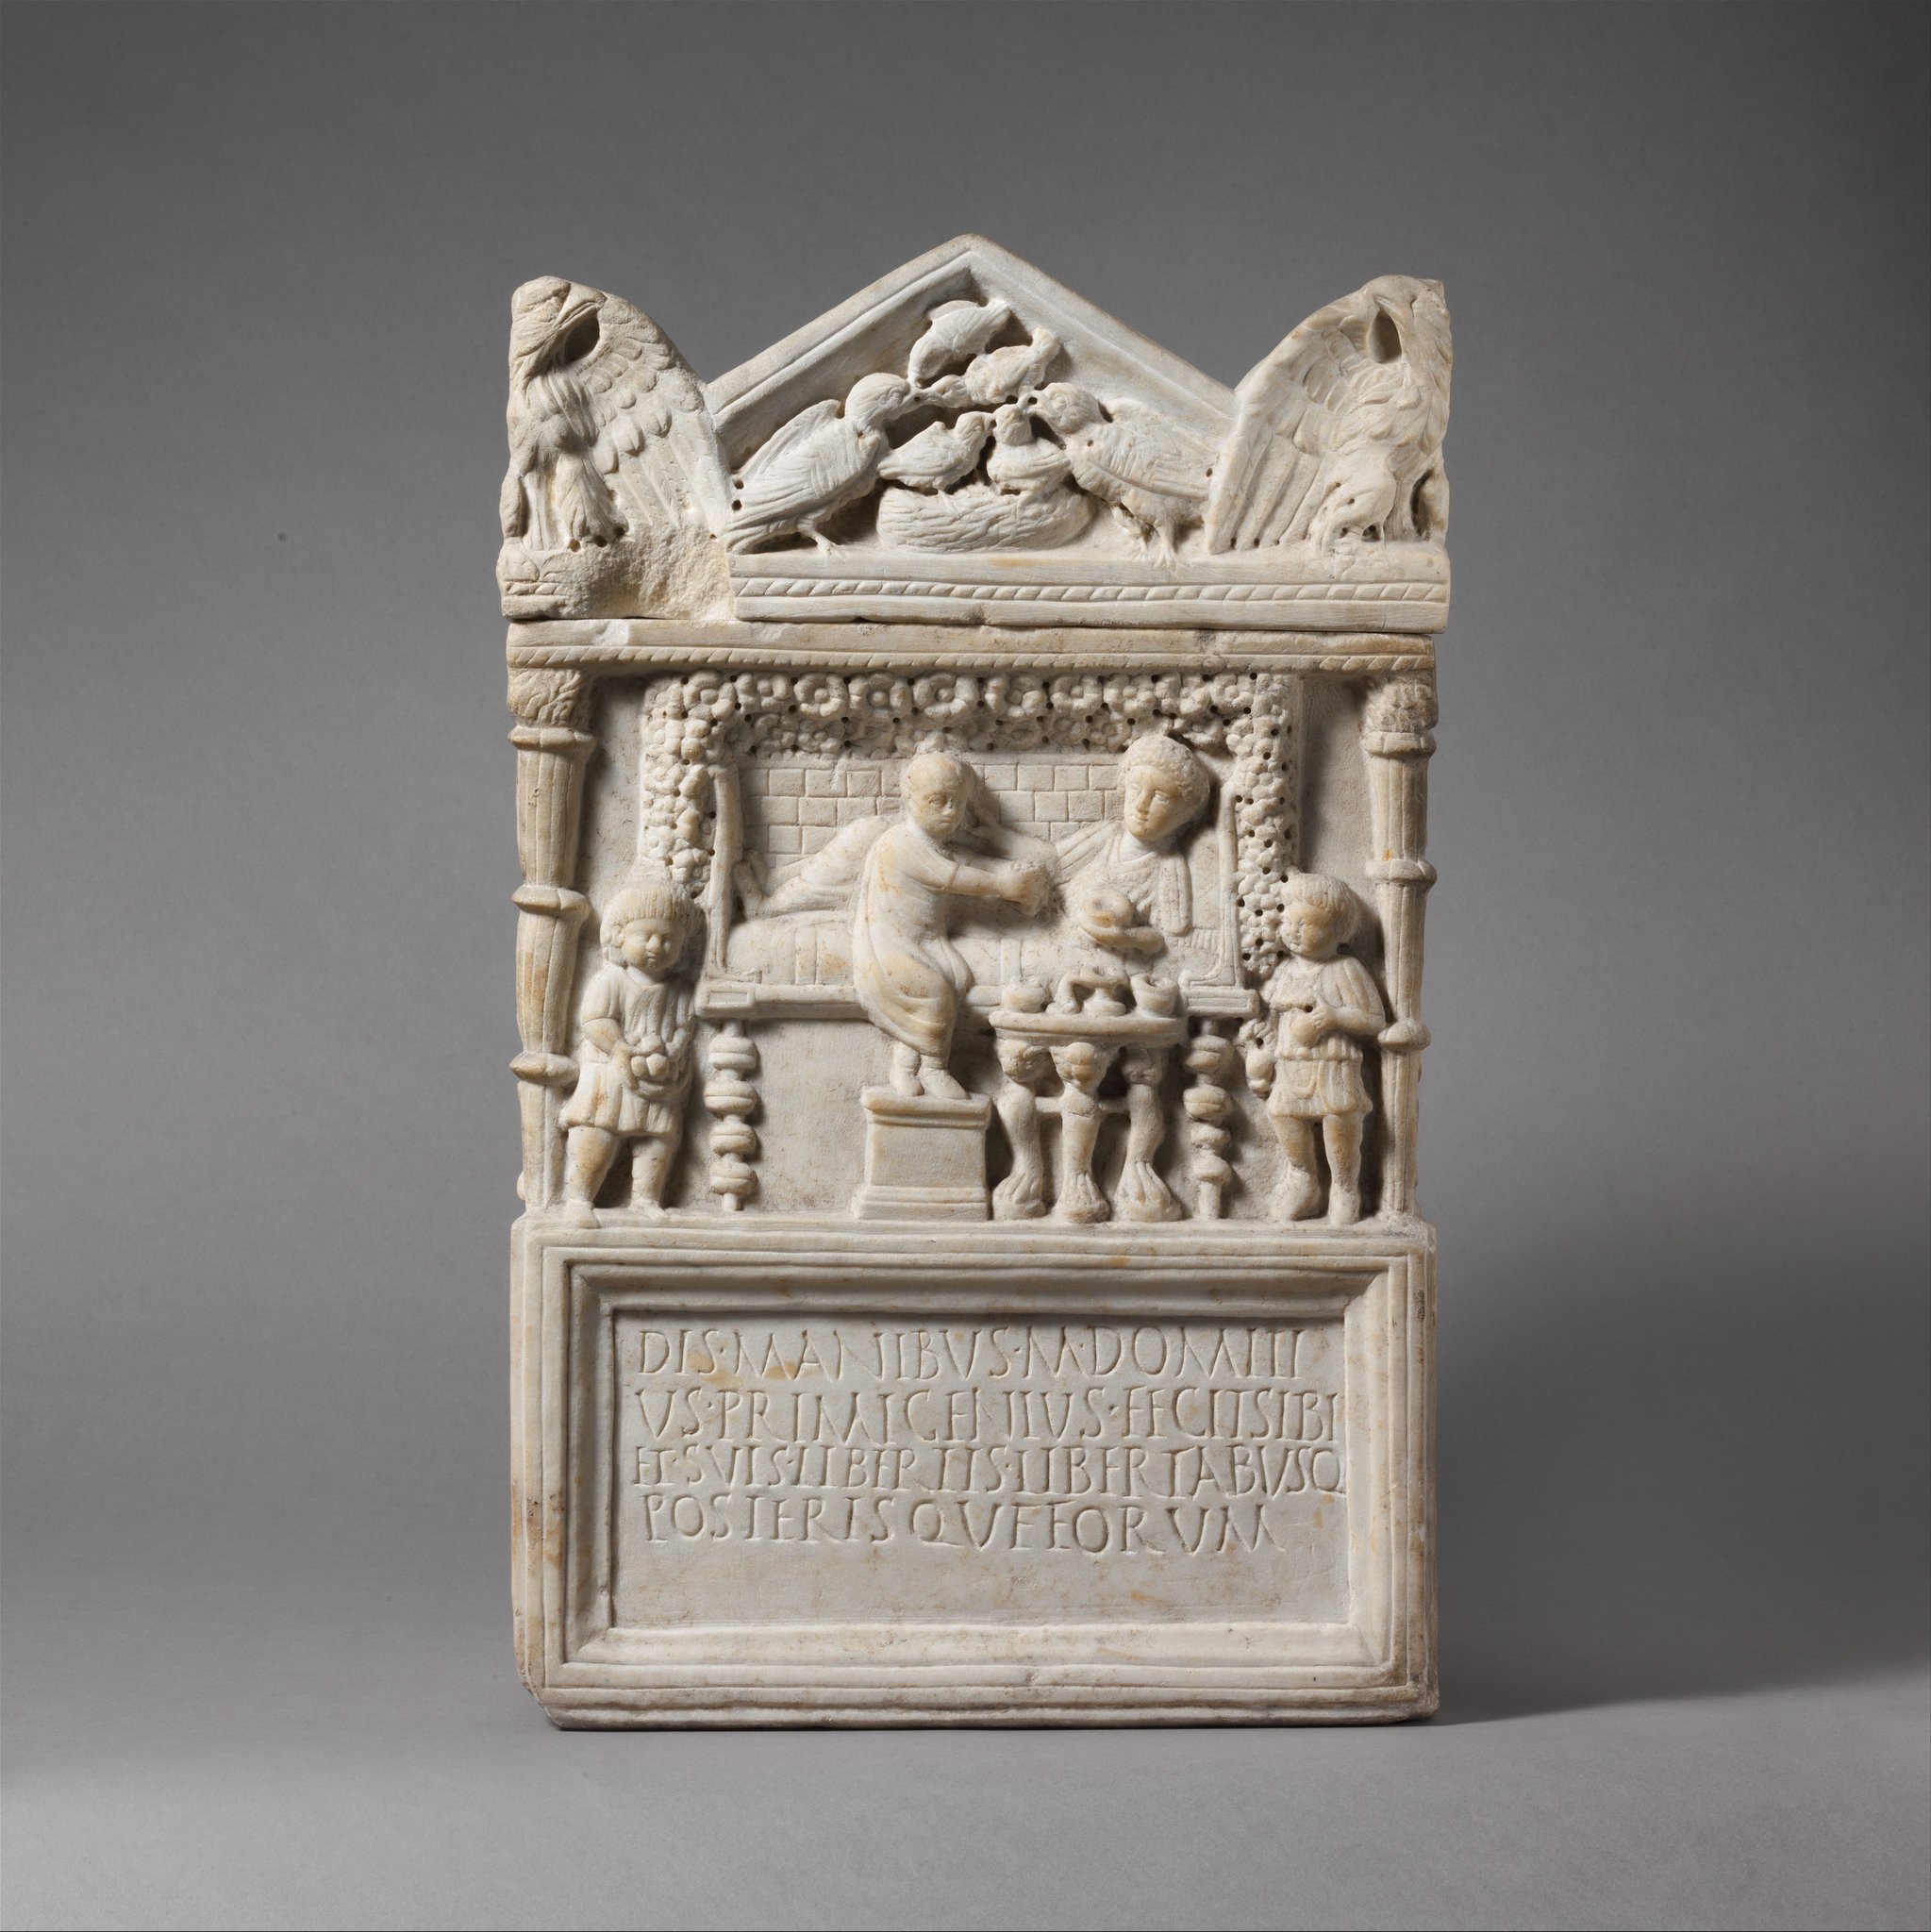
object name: cippus of m. domitius primigenius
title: Marble cinerary chest with lid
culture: roman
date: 90-110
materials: marble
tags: food,birds,men,women,couches